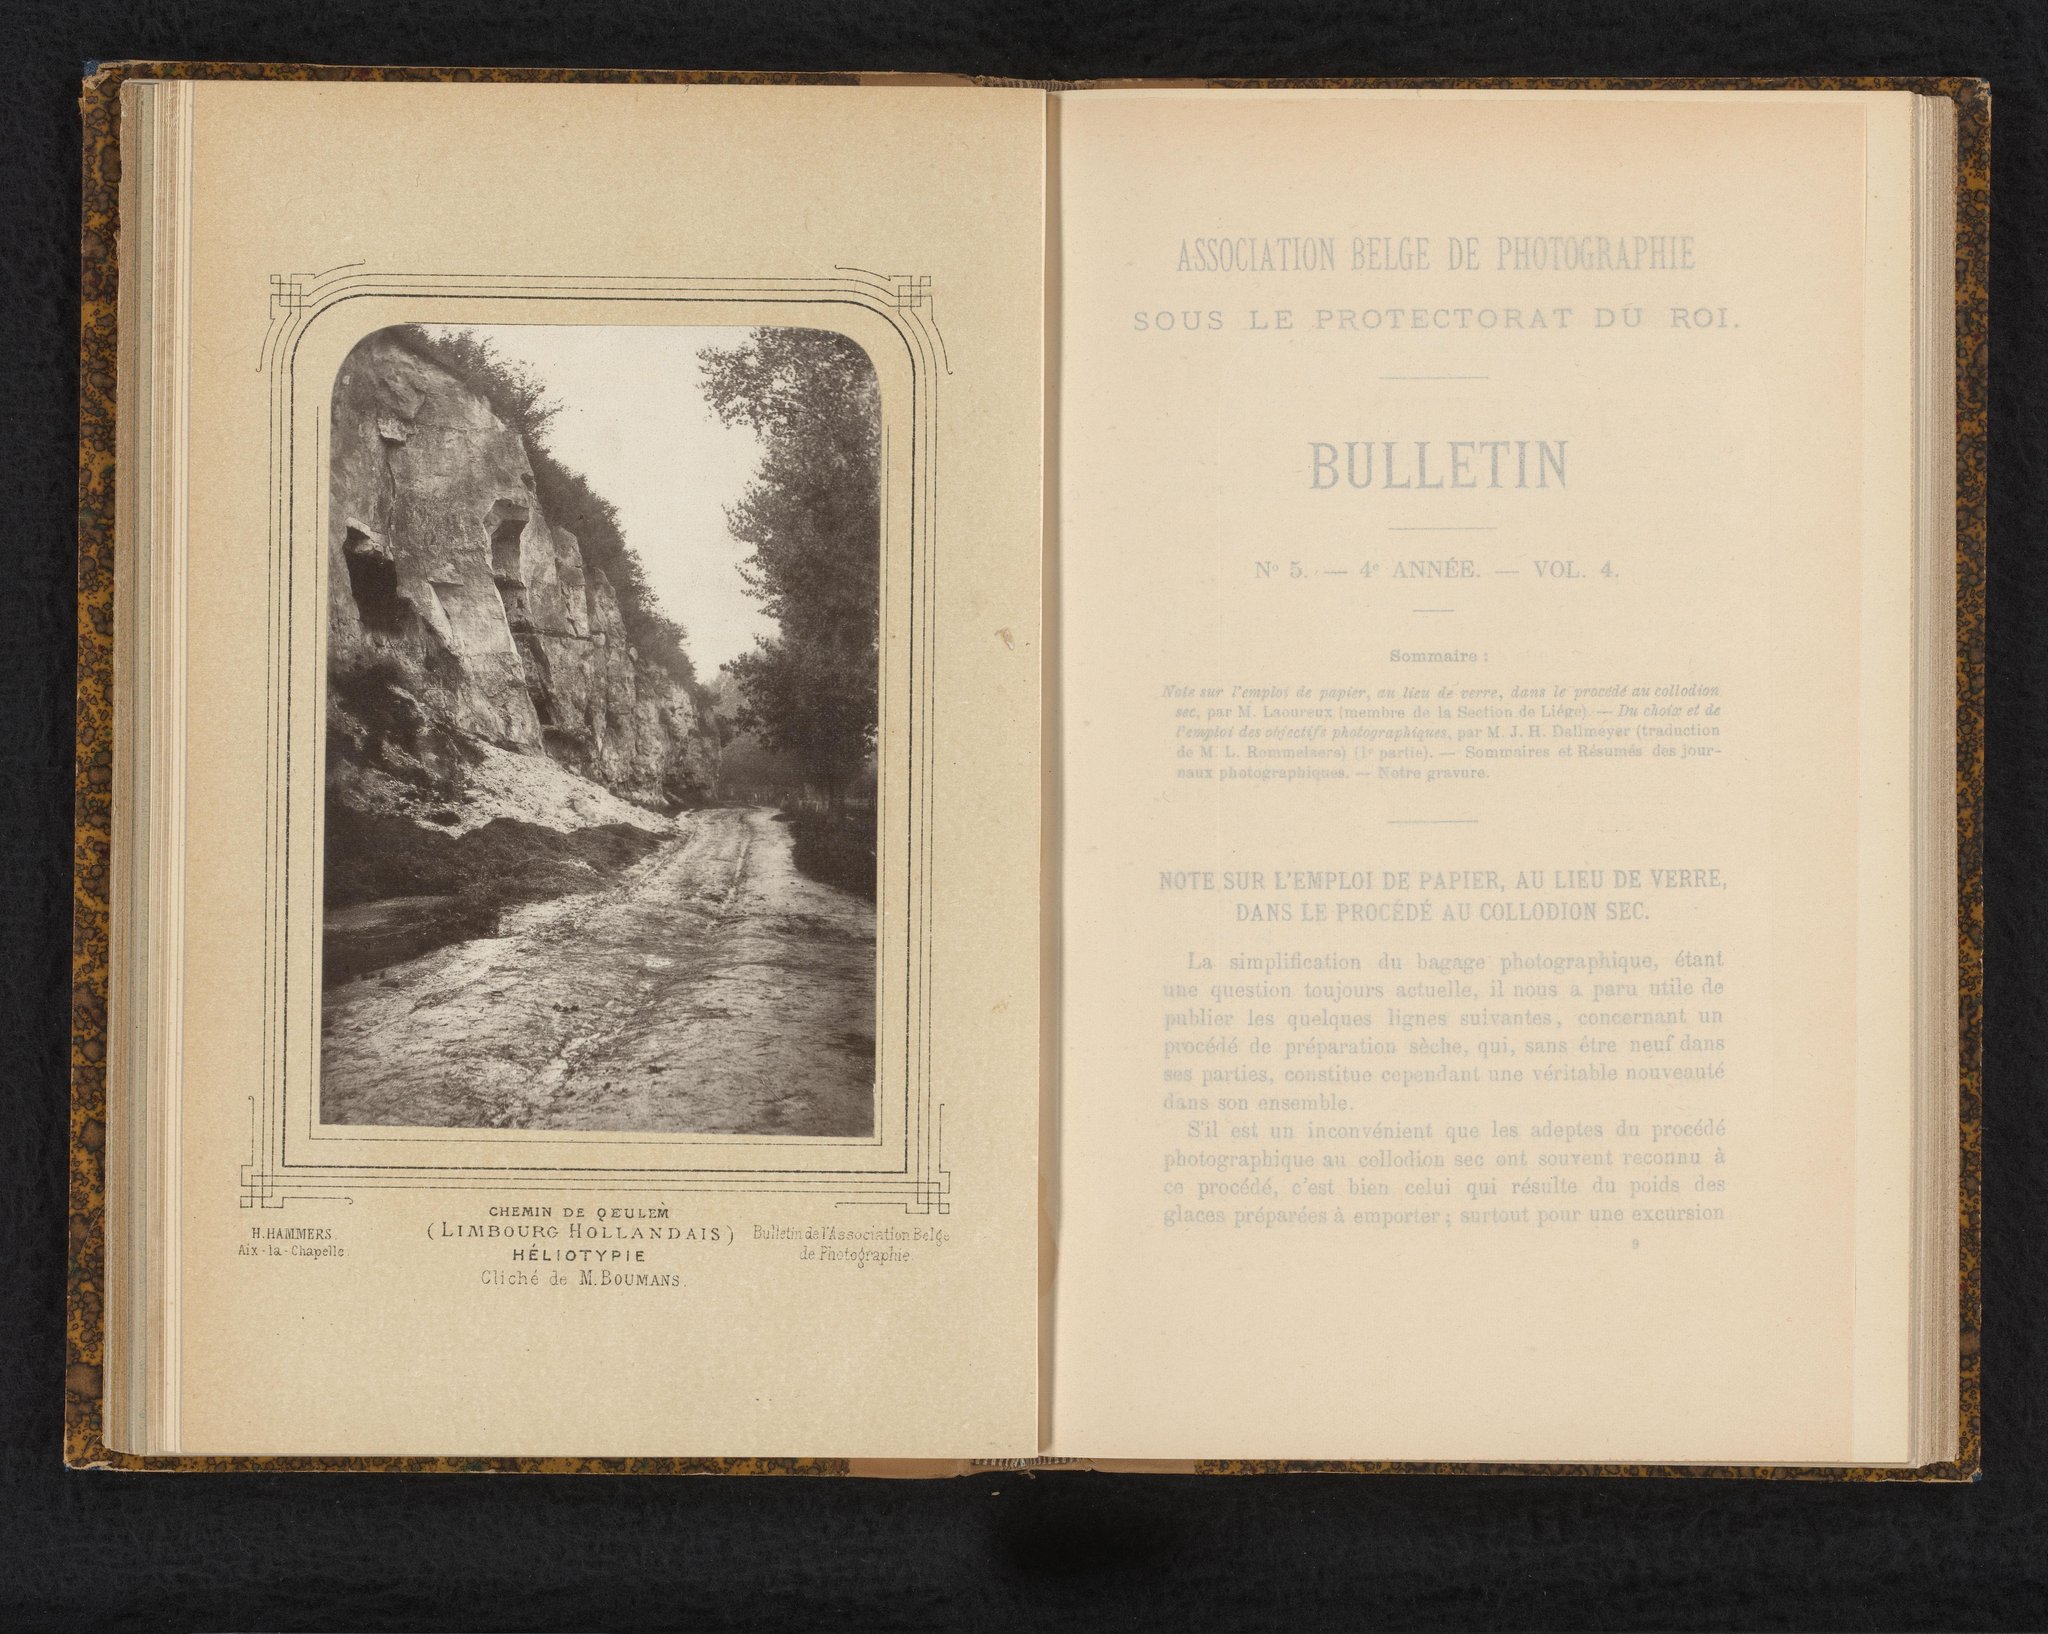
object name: page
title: Chemin de Qeulem (Limbourg Hollandais)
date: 1873-1878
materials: paper, cardboard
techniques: heliotype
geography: aachen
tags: road, path, cave, grotto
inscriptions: inscription: ‘Héliotypie’